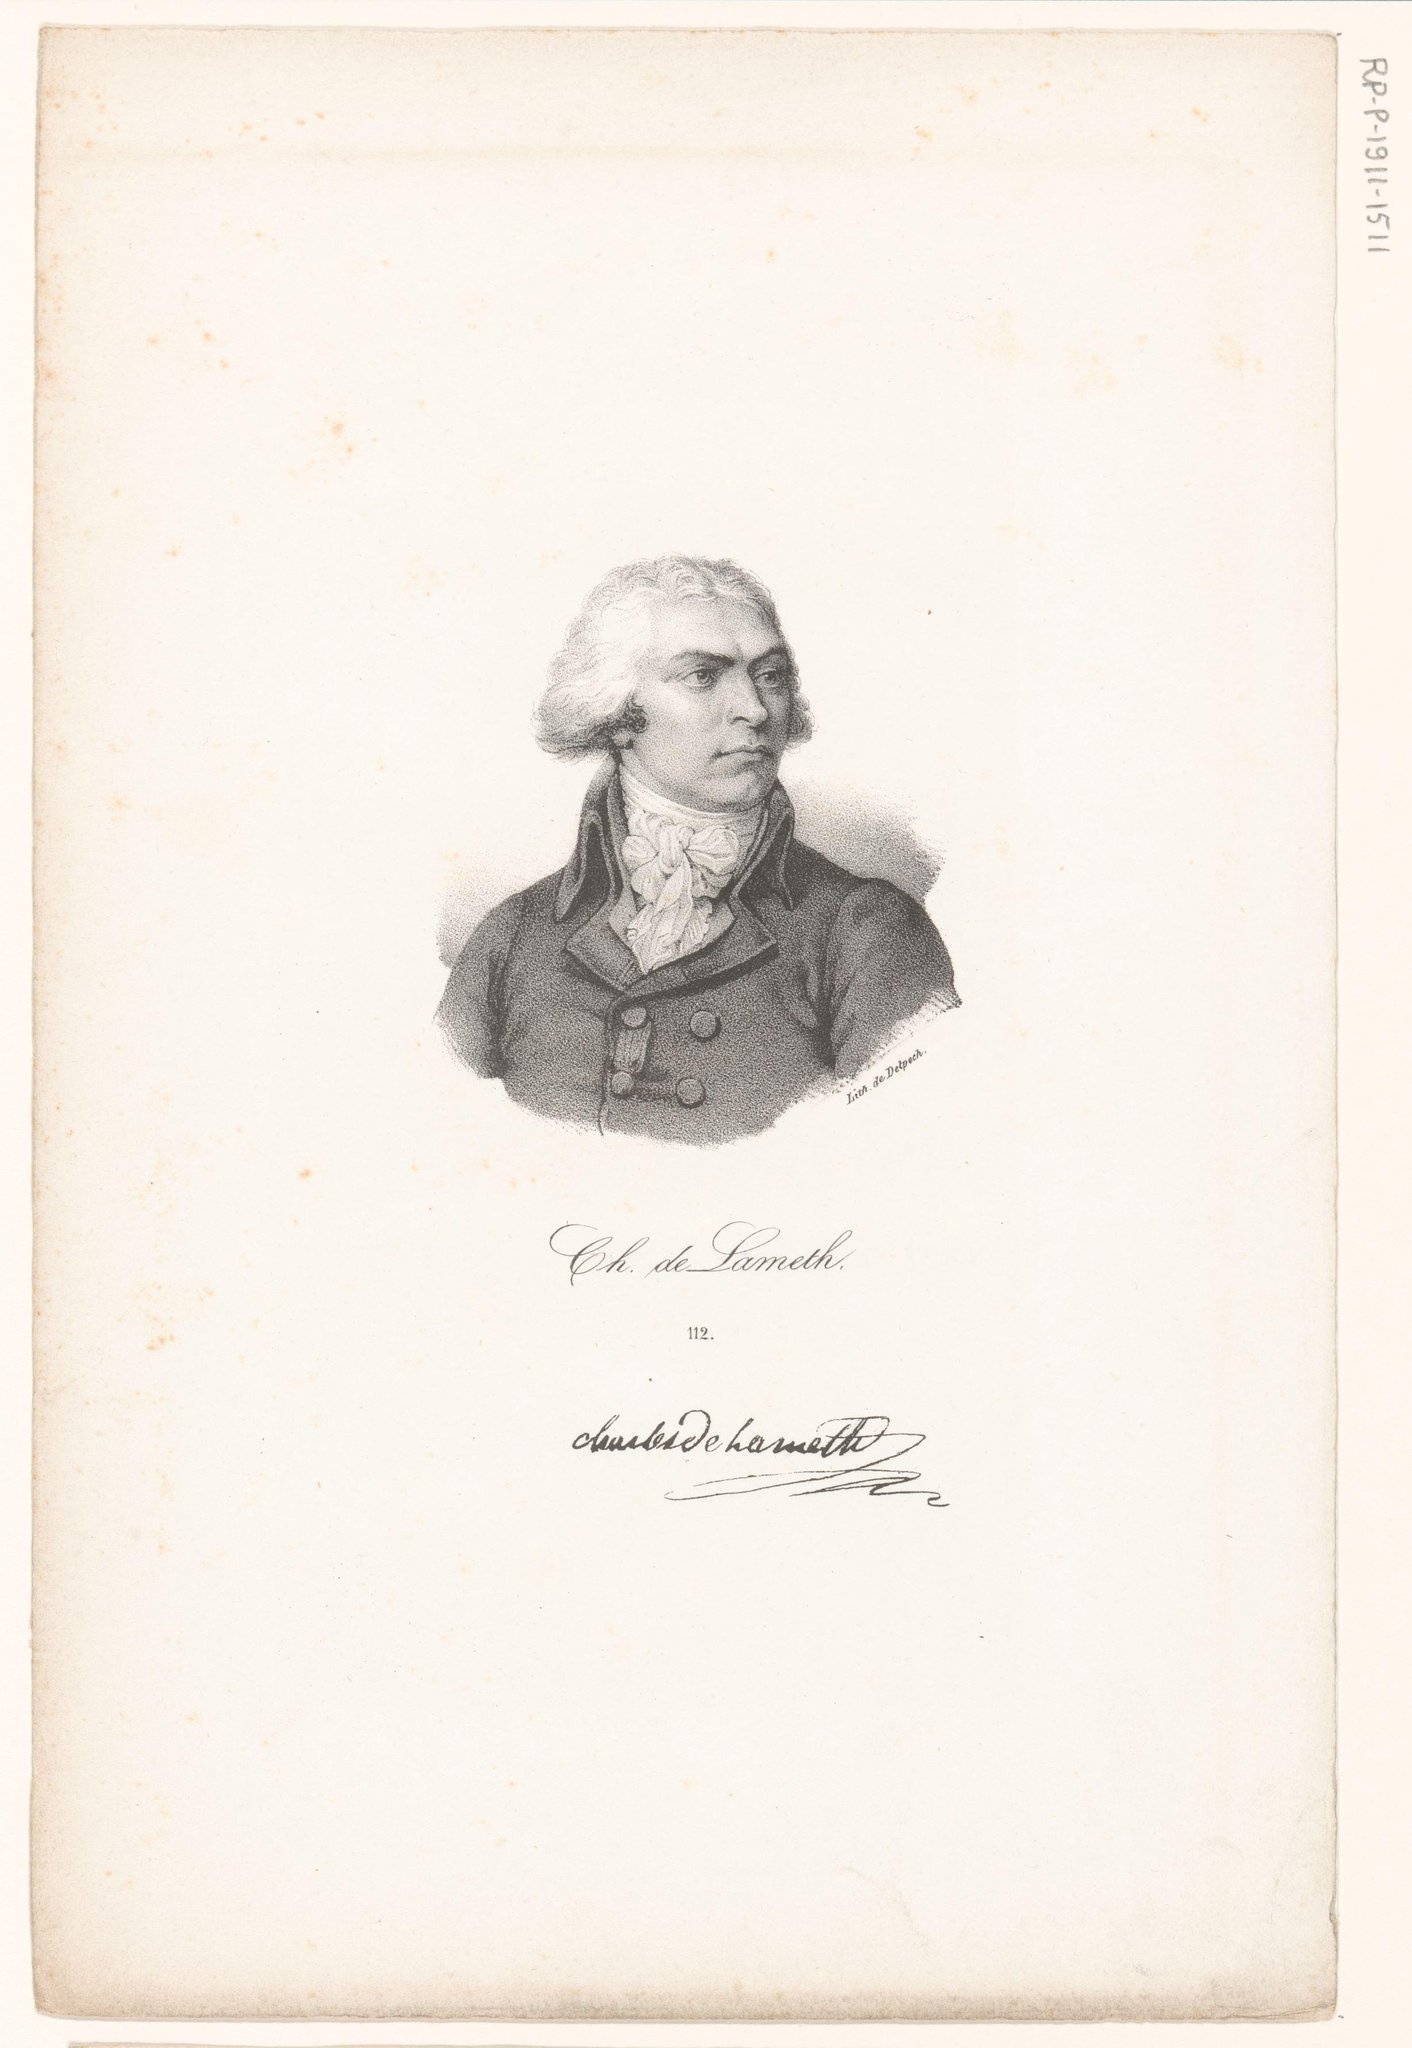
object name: print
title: Portret van Charles-Malo-François de Lameth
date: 1818-1842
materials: paper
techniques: lithograph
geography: paris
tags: historical persons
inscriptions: collector's mark: Lugt 2228a